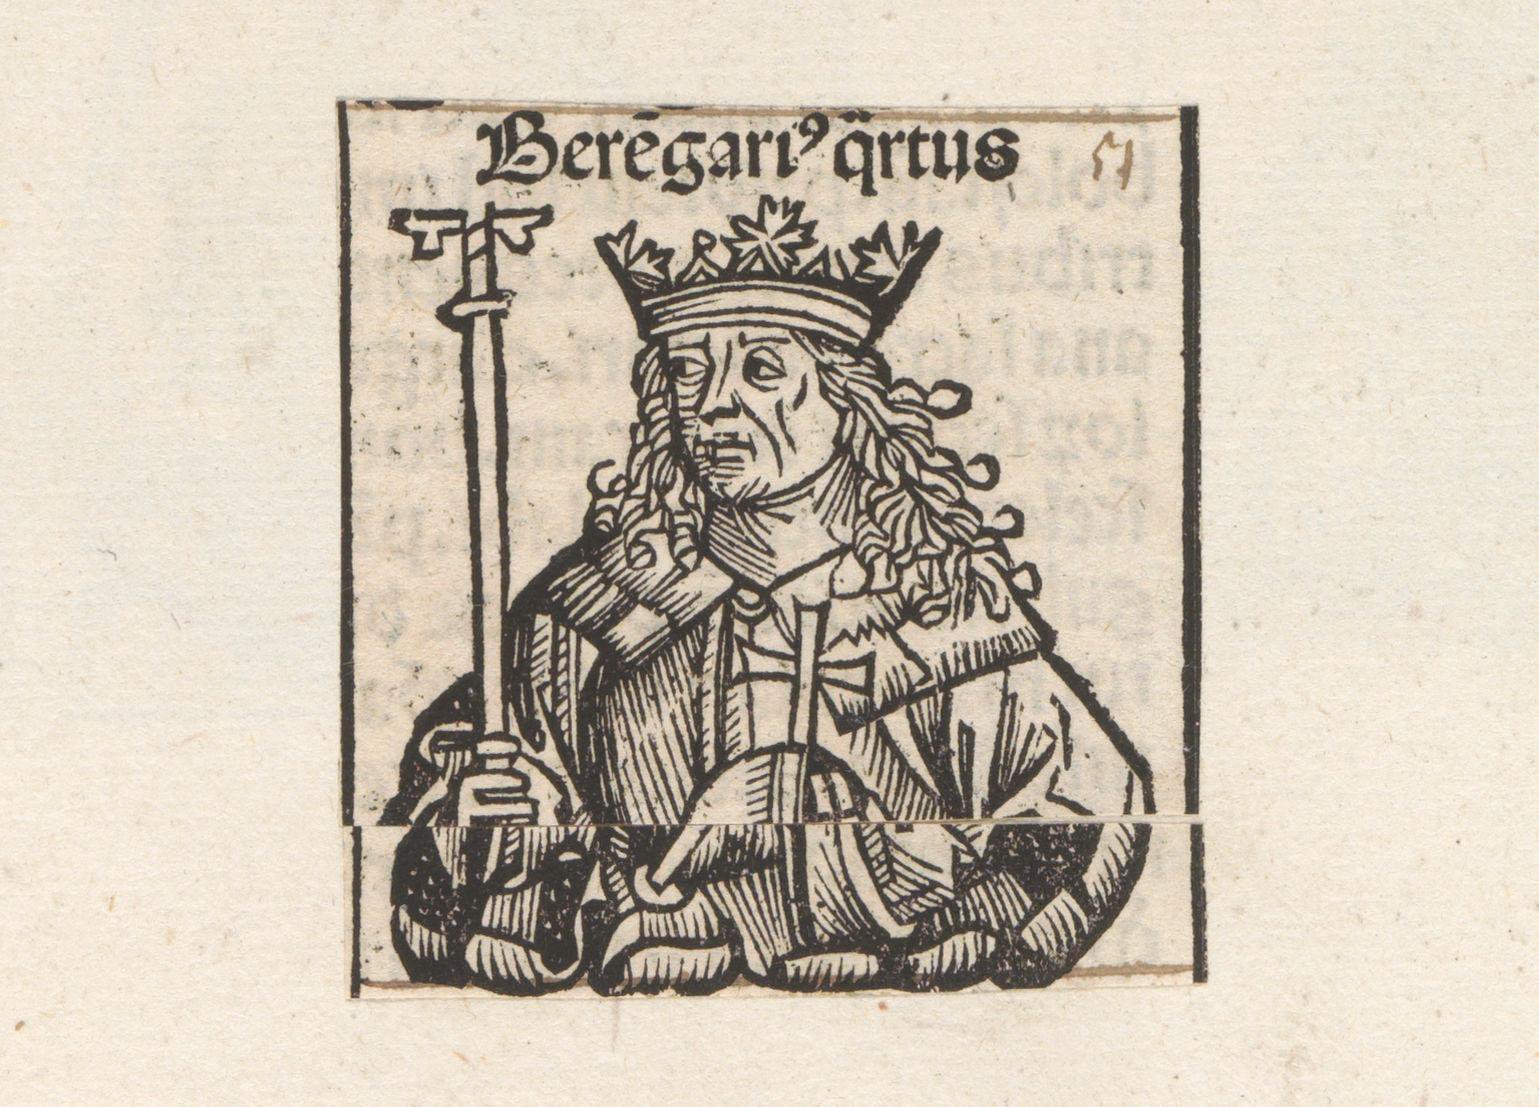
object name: album leaf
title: Bere[n]gari[us] q[ua]rtus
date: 1493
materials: paper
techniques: letterpress printing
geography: nuremberg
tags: emperor, king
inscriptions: inscription: ‘51’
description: Voorstelling in twee delen. Een bloemkelk met een koning, naar links gekeerd. In zijn handen heeft hij een rijksappel en een scepter. De voorstelling is onderdeel van de opeenvolging keizers in de Liber Chronicarum. De tekst identificeert de man als Berengarius II (hier Berengarius IV genoemd). De prent maakt deel uit van een album.